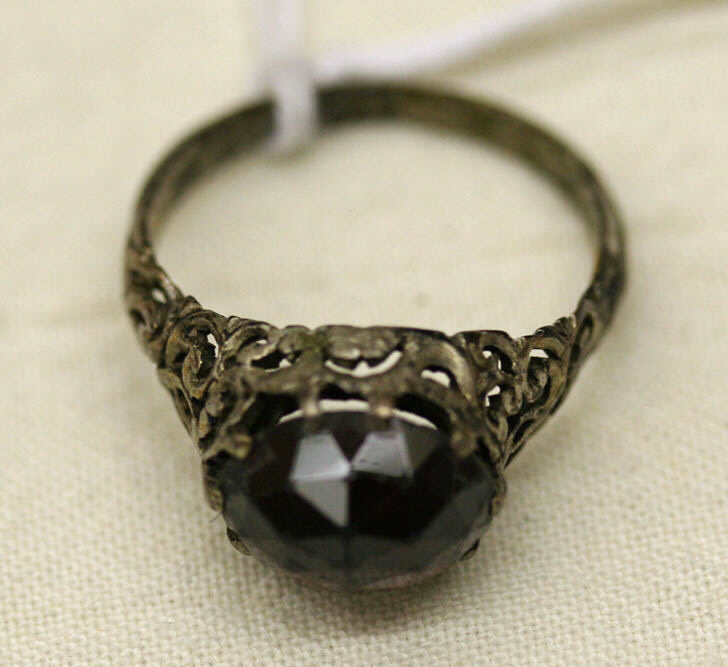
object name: ring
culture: european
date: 1701-1800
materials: metal